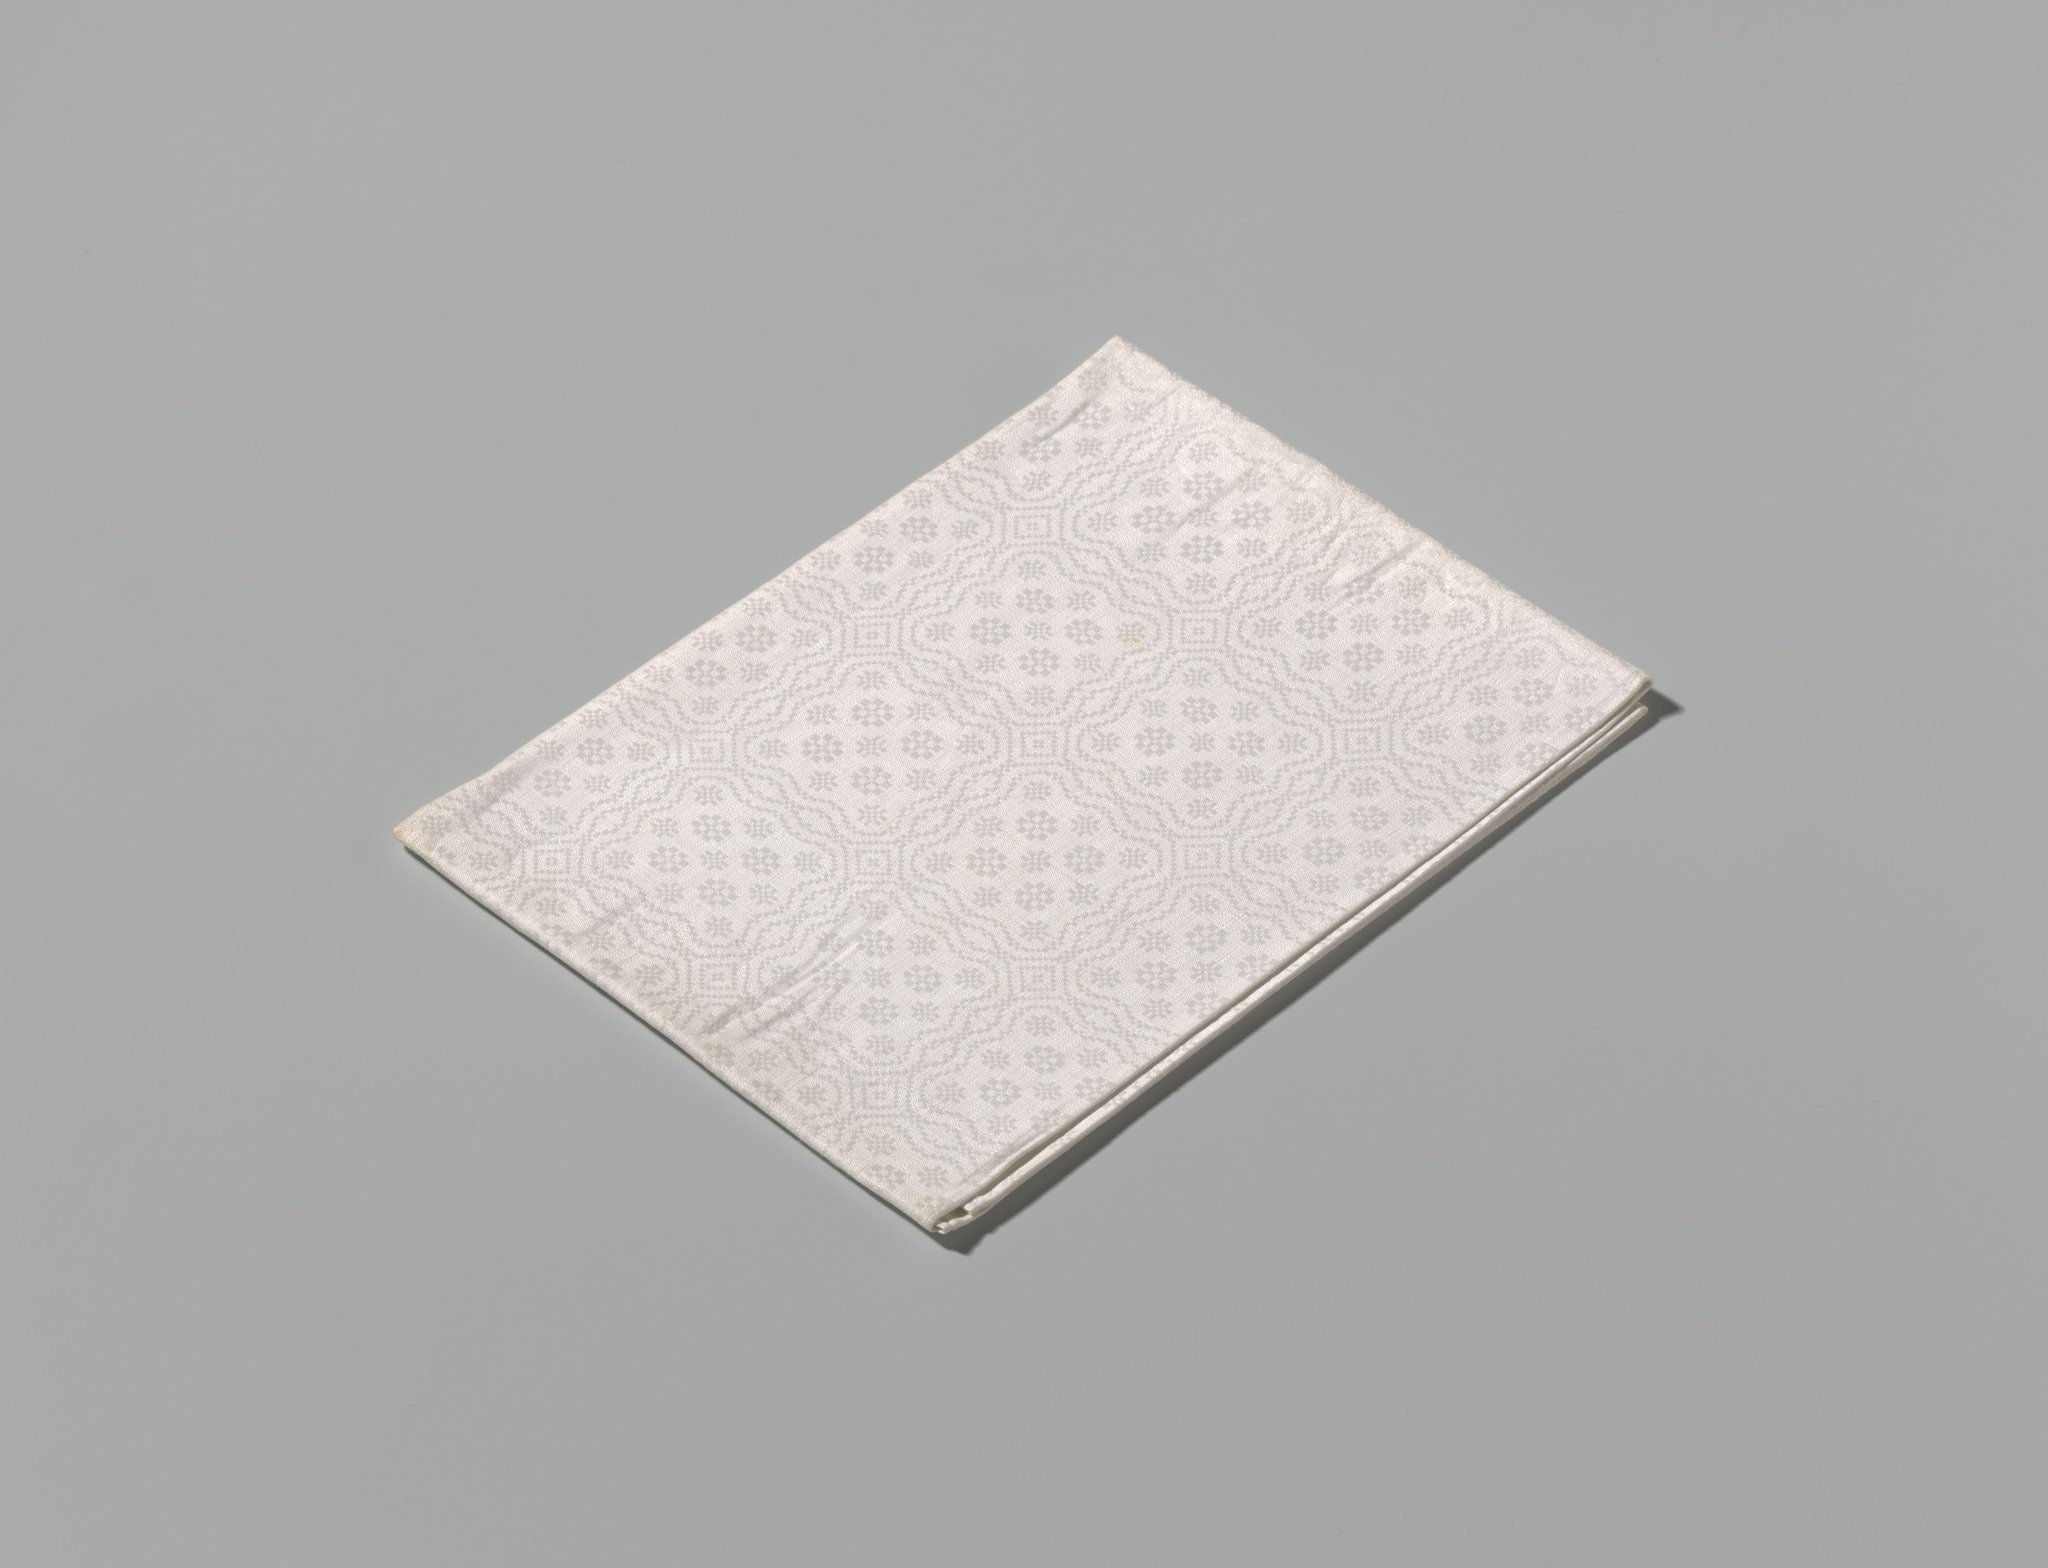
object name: napkin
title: Servet van linnen met pellenpatroon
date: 1692-1735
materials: linen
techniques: peeled fabric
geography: northern netherlands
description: wit linnen servet met pellen patroon, merk GS 36